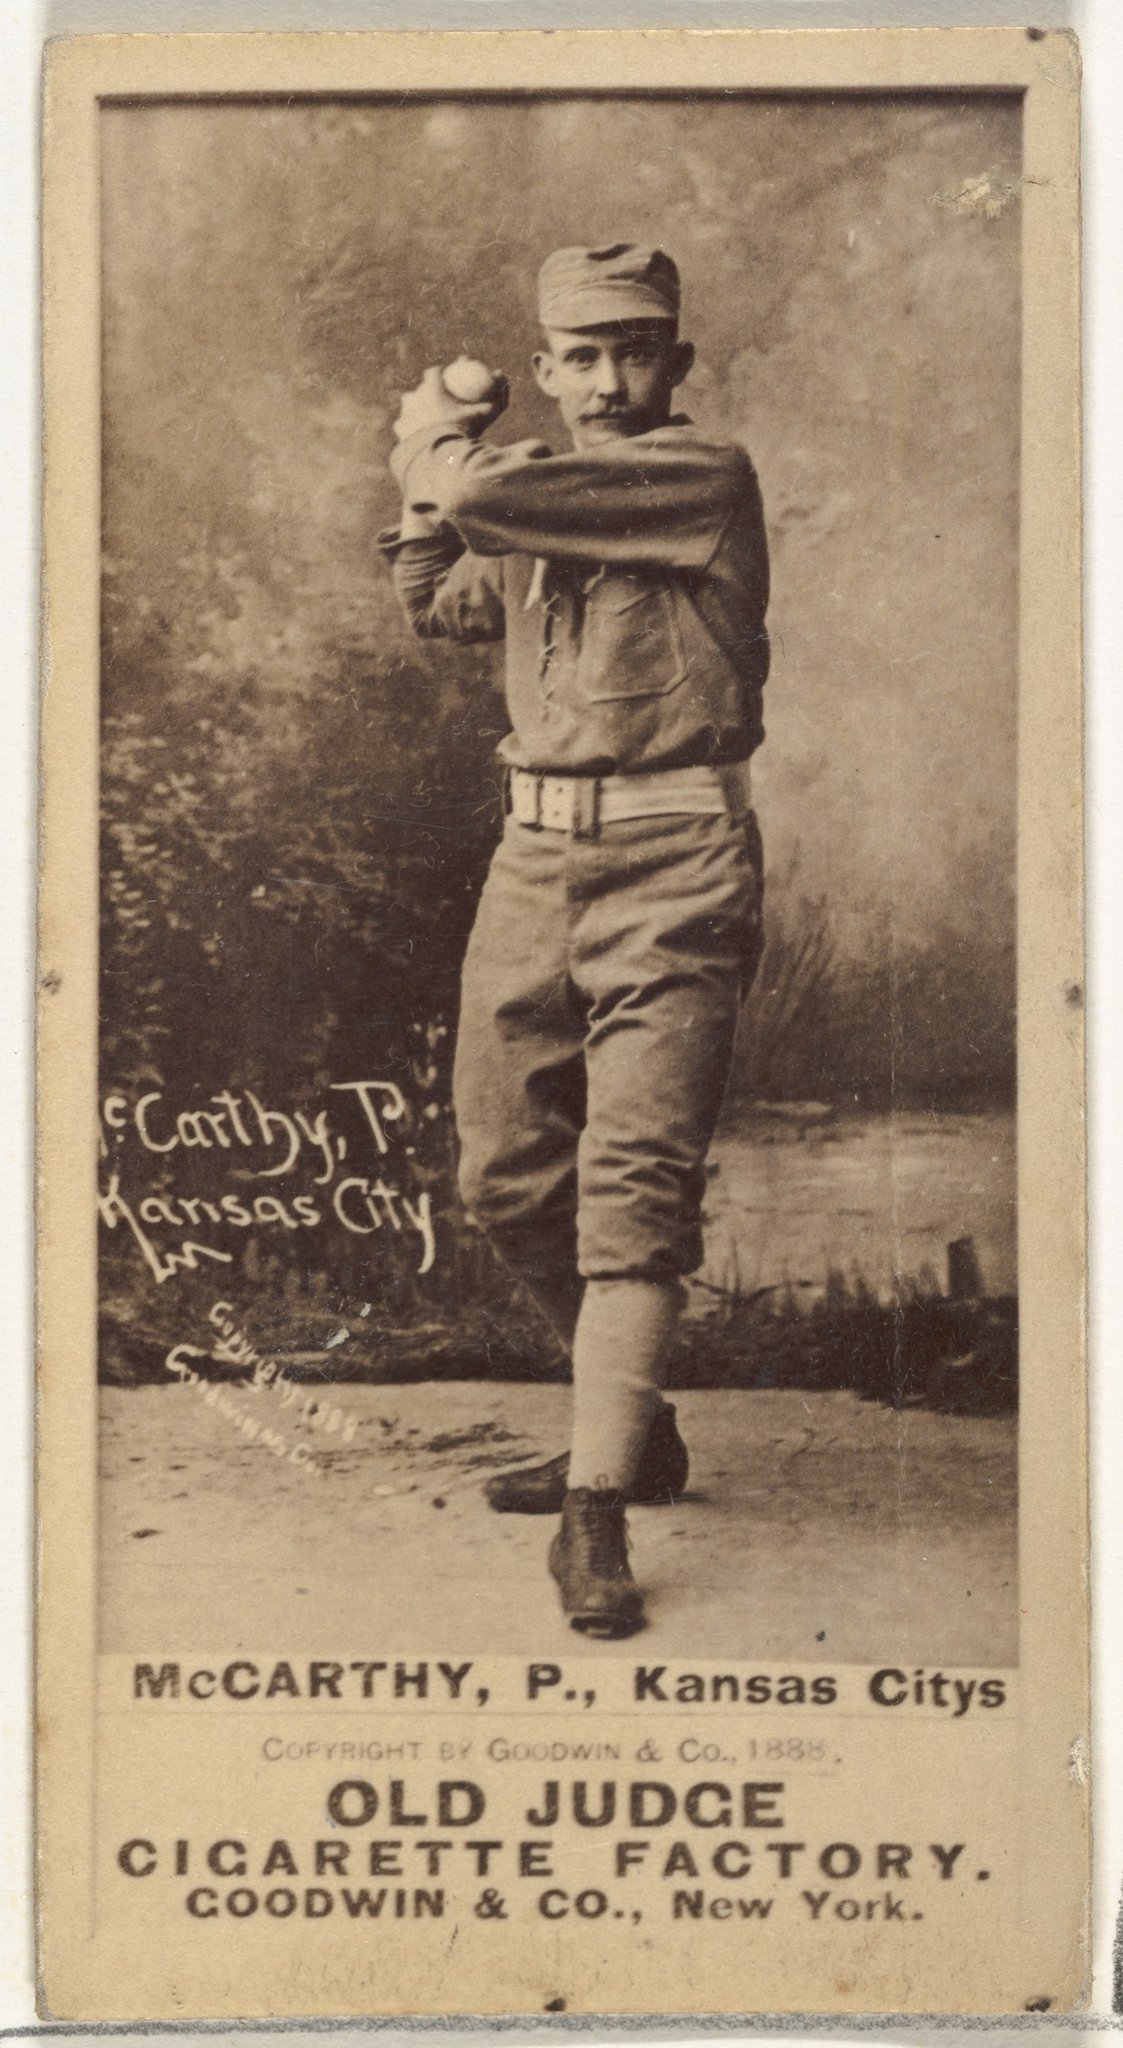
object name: baseball card, photograph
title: John A. McCarty, Pitcher, Kansas City Cowboys, from the Old Judge series (N172) for Old Judge Cigarettes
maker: goodwin & company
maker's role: publisher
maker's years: 1850-1950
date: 1888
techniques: albumen silver print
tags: men,portraits,baseball,athletes